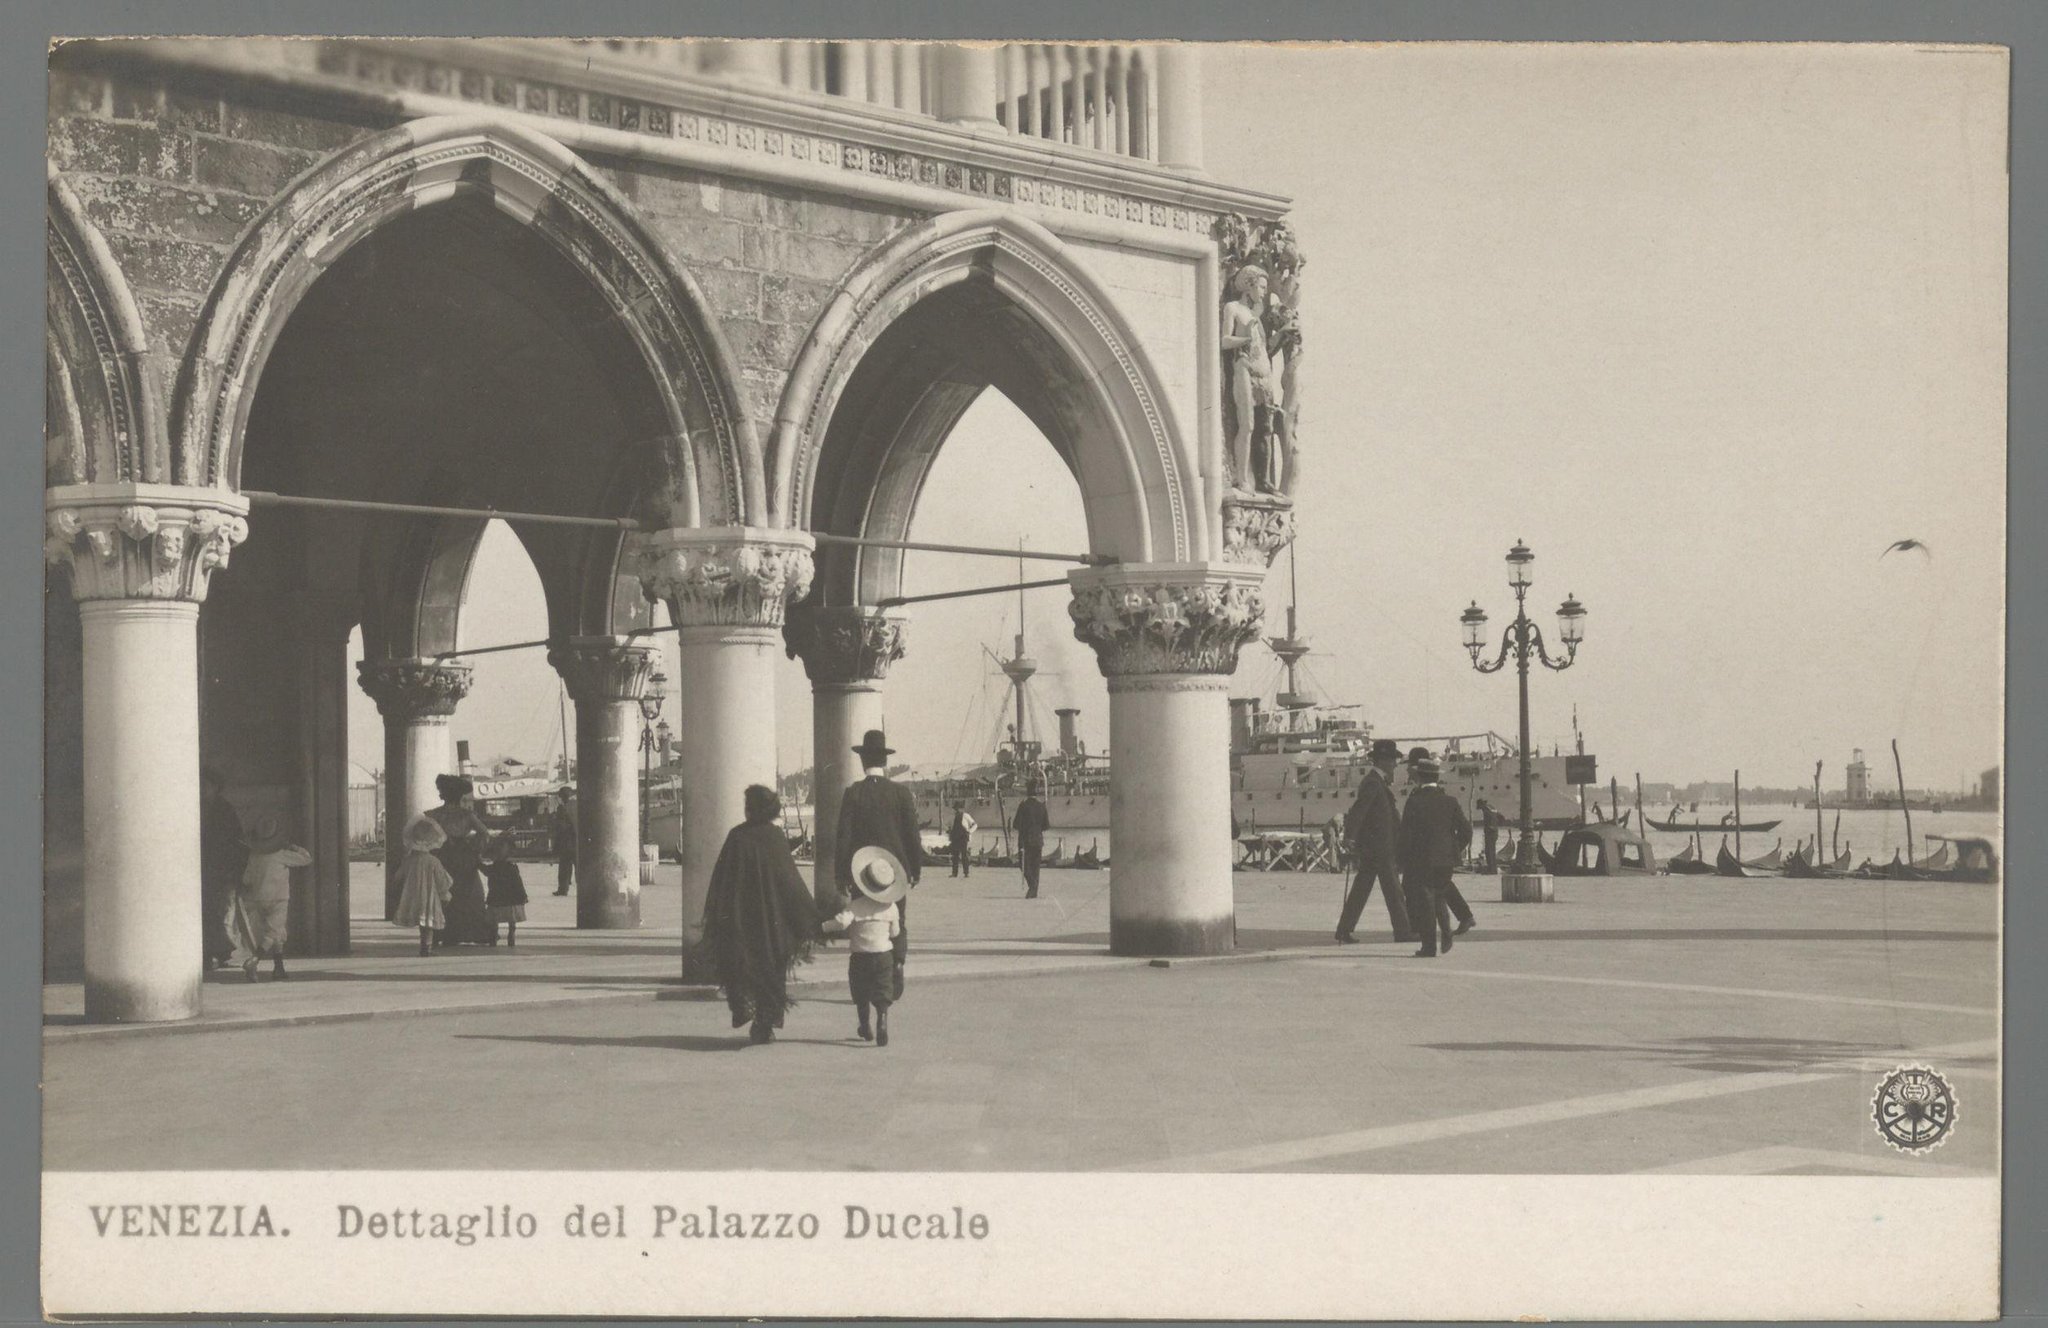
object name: ansichtkaart, prentbriefkaart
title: Venezia. Dettaglio del Palazzo Ducale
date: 1900-1906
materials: photographic support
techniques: photography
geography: venice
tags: palace, ships (in general), square, place, circus, etc. (+ city(-scape) with figures, staffage)